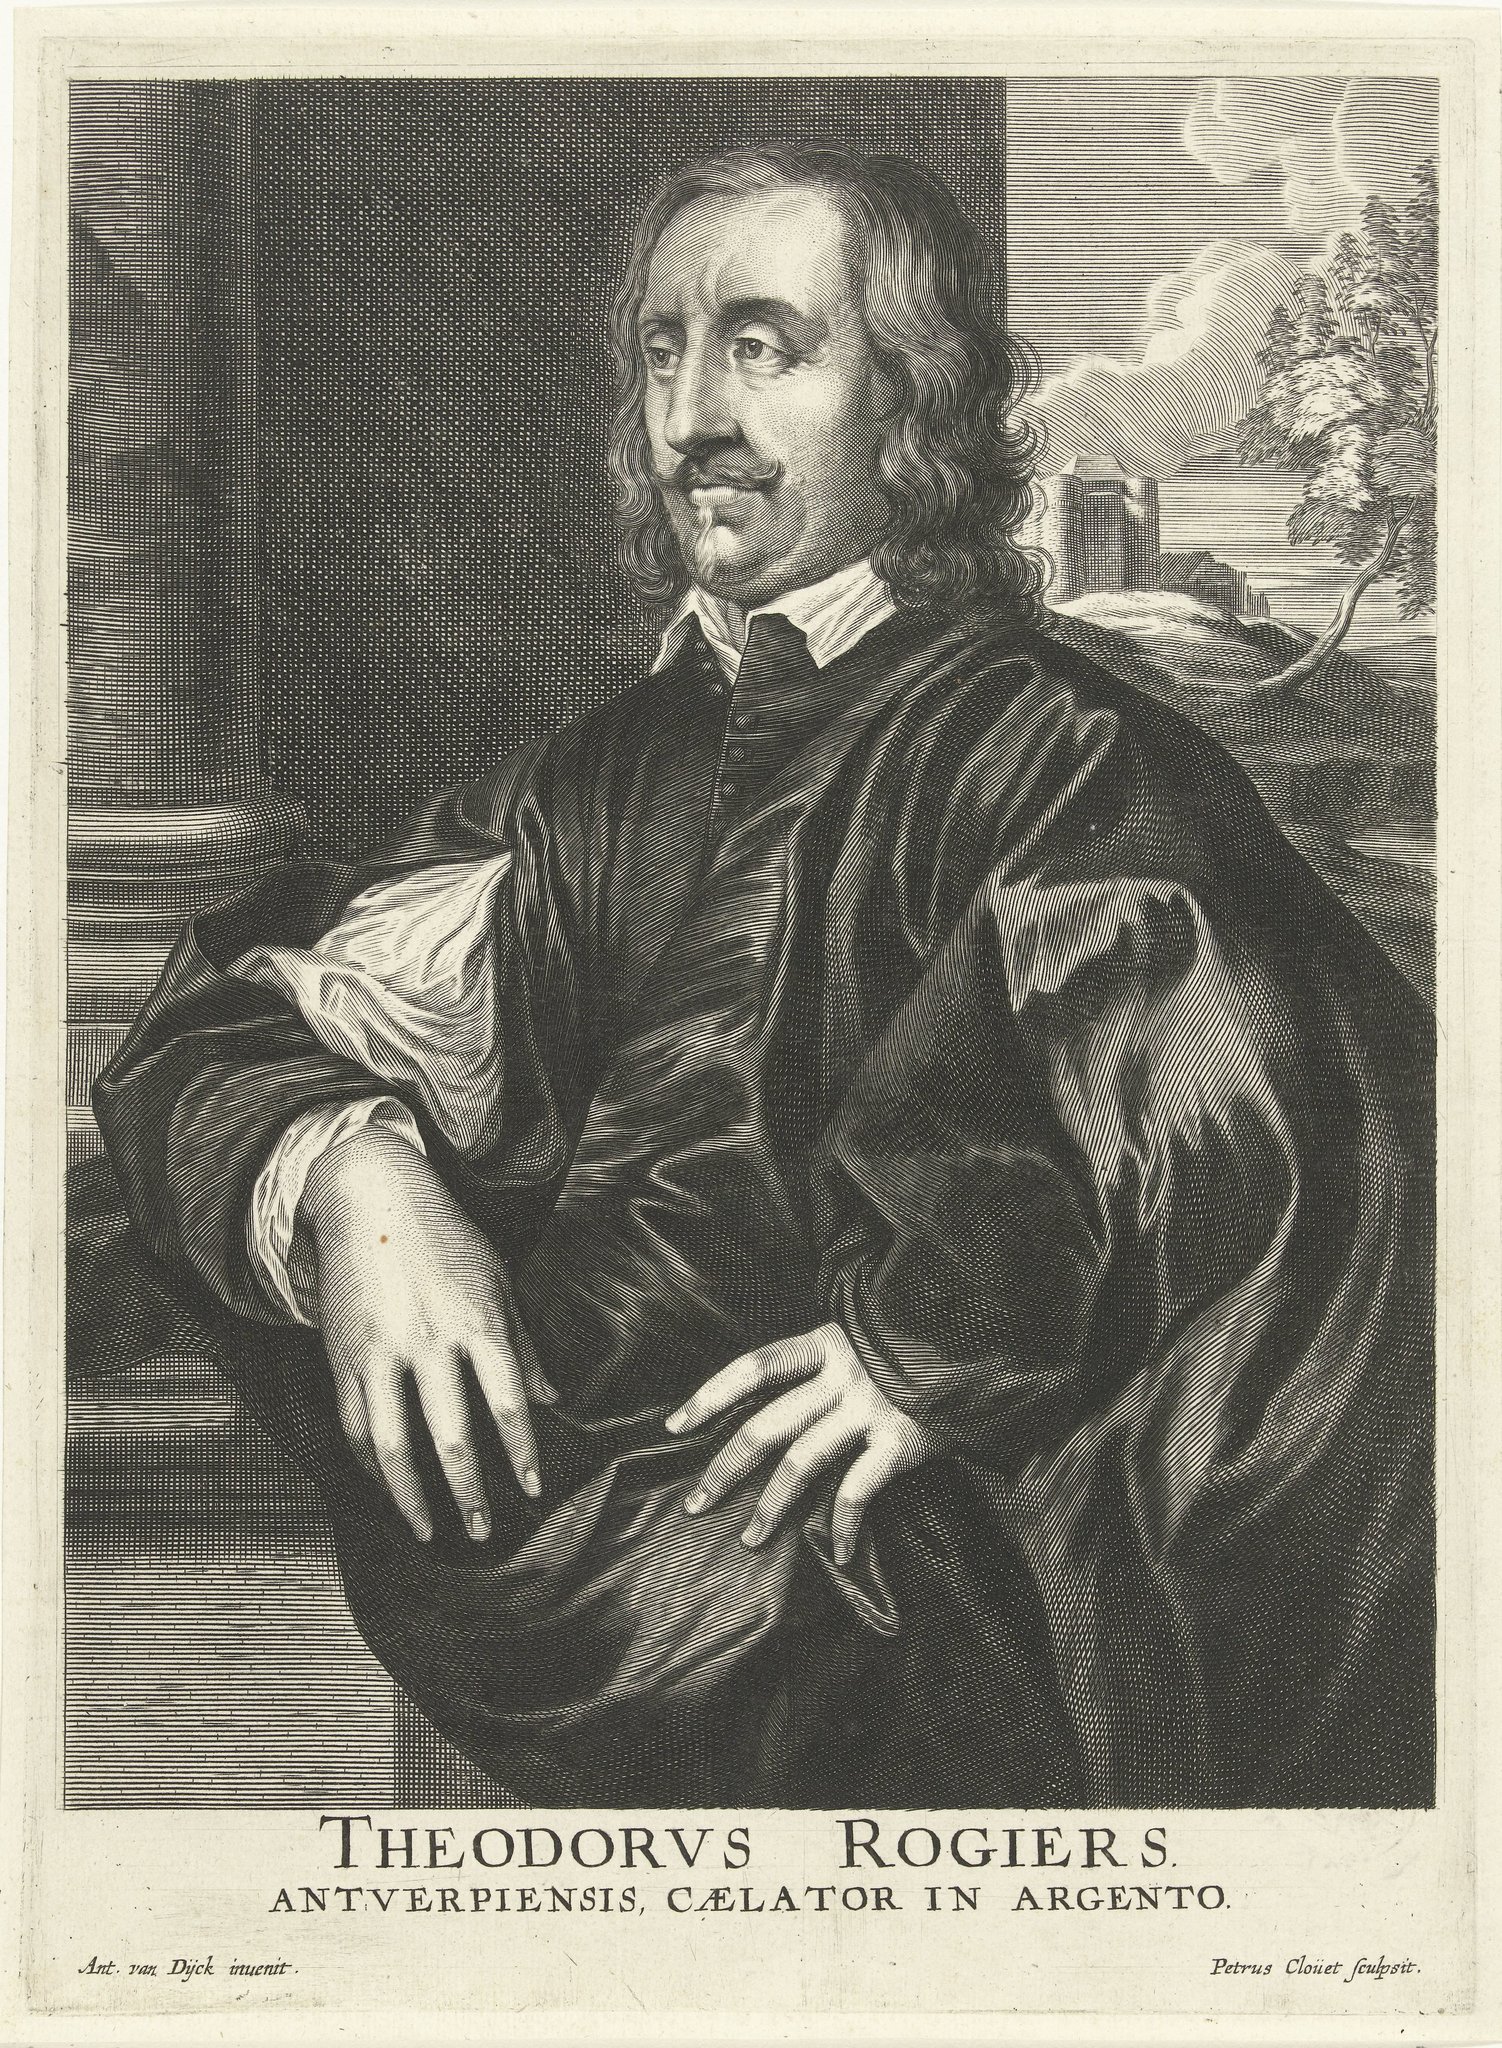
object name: print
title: Portret van Theodor Rogiers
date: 1639-1670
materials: paper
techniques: engraving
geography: antwerp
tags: goldsmith, silversmith, theodoor rogiers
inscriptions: collector's mark: Lugt 240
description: Portret van Theodor Rogiers, een Antwerpse goudsmid. Buste naar links.